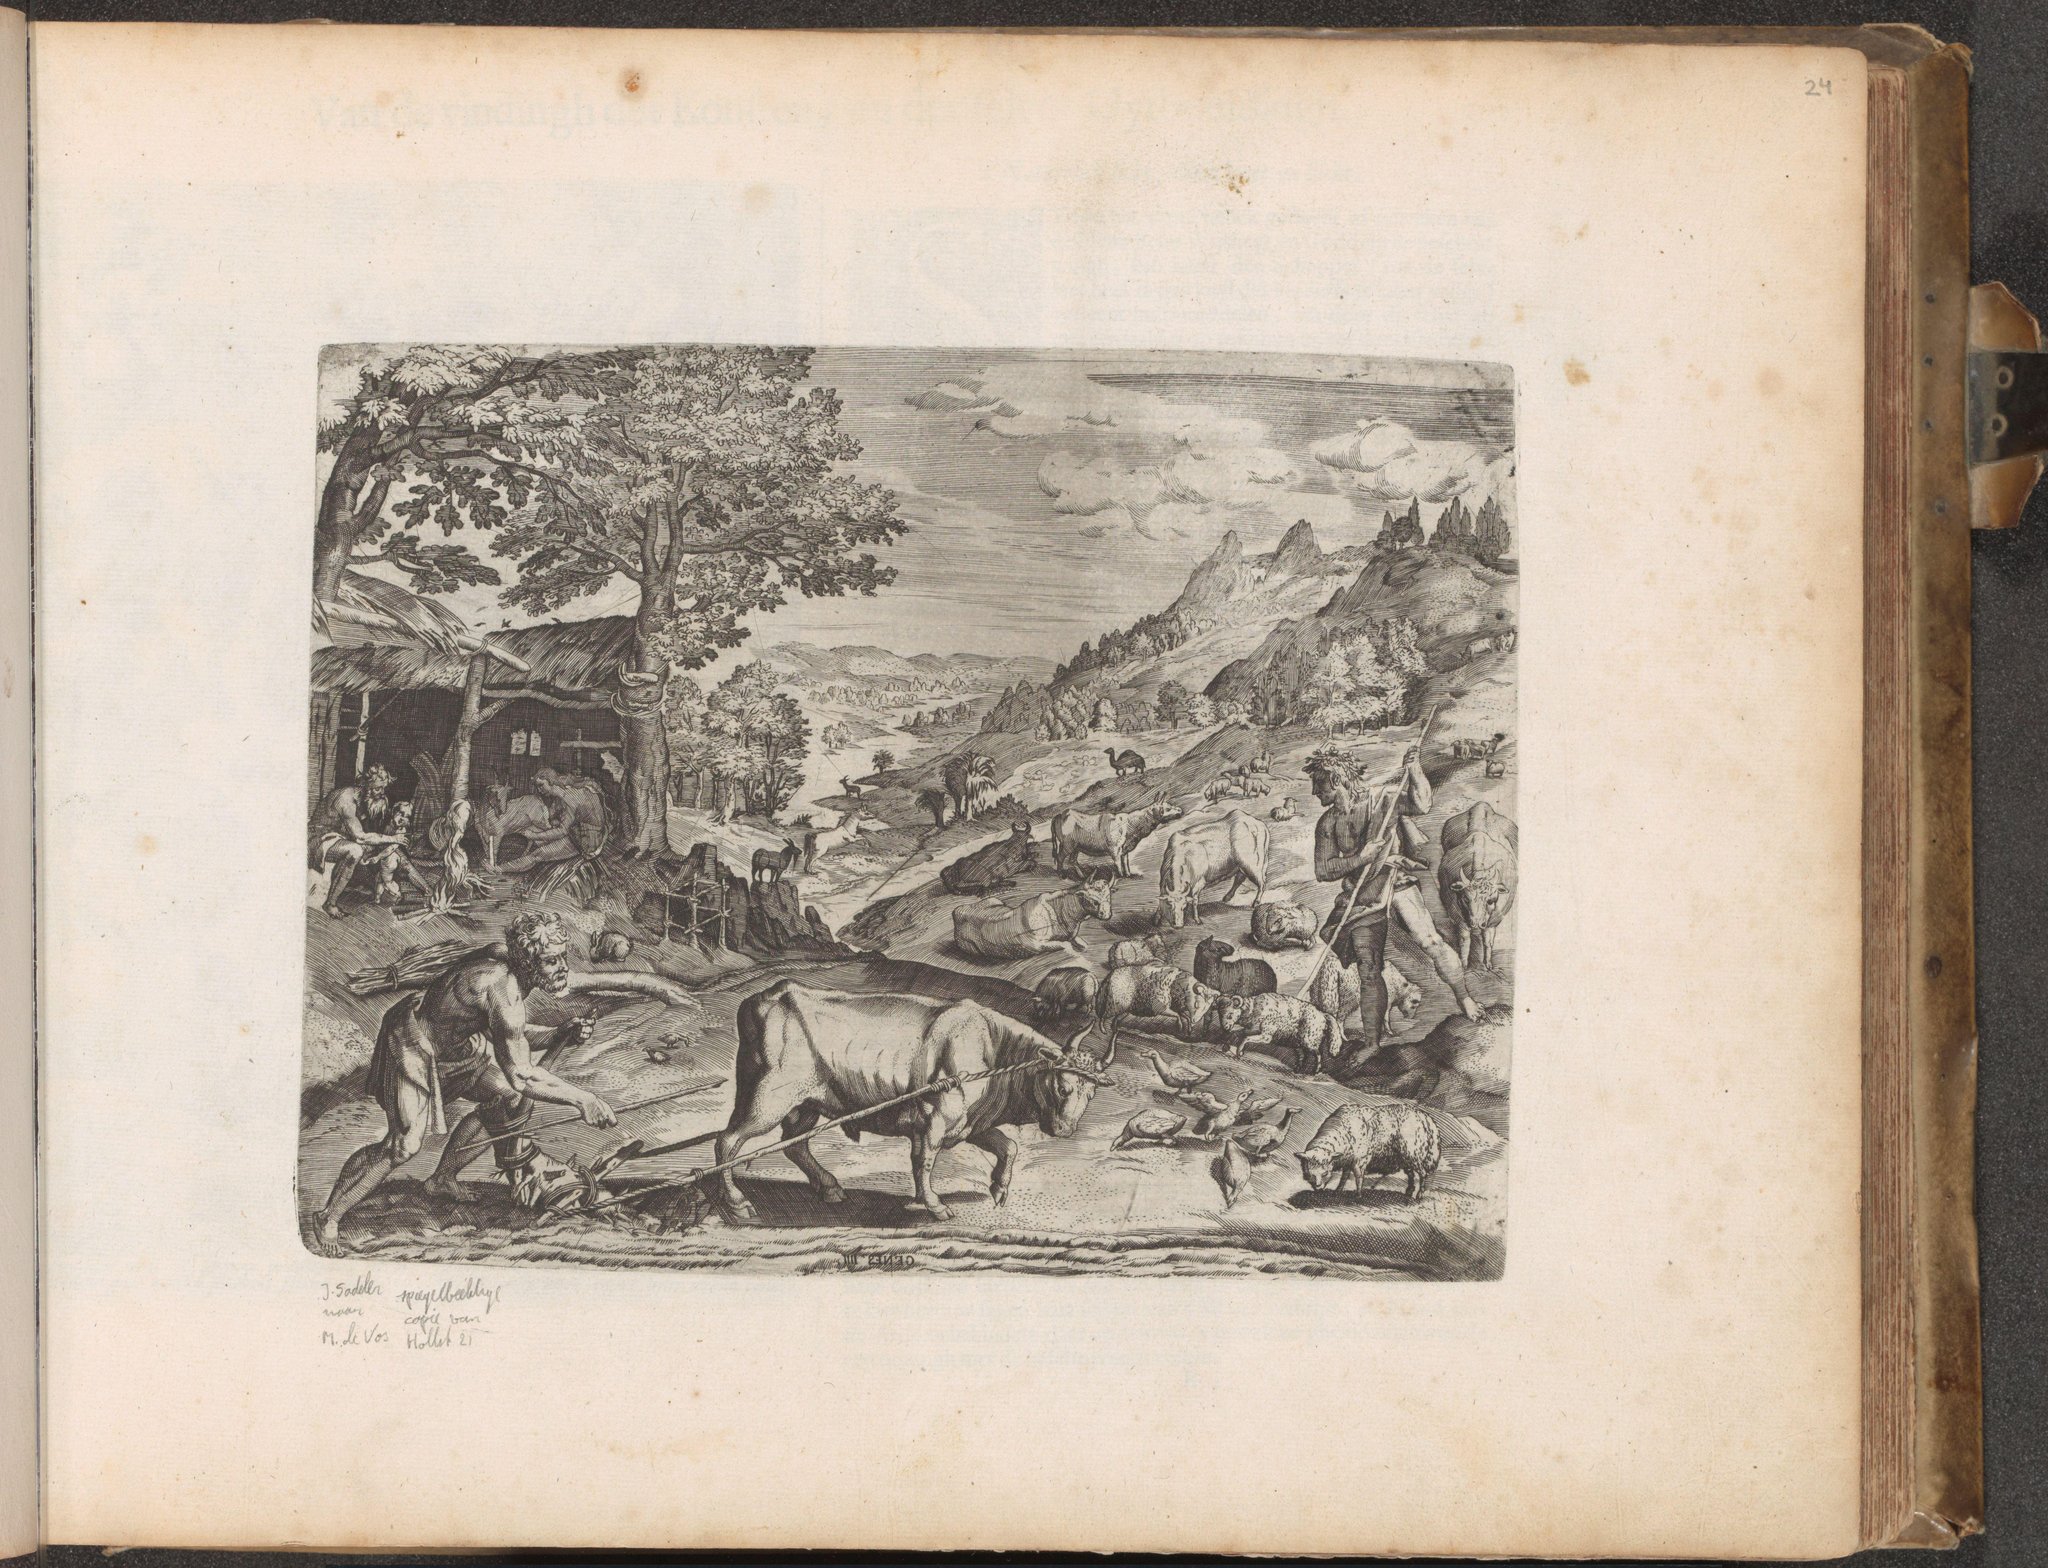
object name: album leaf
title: Den Grooten Emblemata Sacra, bestaande in meer dan vier hondert bybelsche figuren, zoo des Ouden als des Nieuwen Testaments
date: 1583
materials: paper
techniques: engraving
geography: amsterdam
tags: cain and abel learn to assist their father; cain by farming, abel by herding, animals, old testament, declining years and death of adam and eve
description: Kaïn ploegt een veld met een trekos. Rechts zorgt Abel voor een kudde koeien en schapen. Op de achtergrond links de hut van Adam en Eva. Midden onder een verwijzing (in spiegelbeeld) naar de Bijbeltekst in Gen. 4. De prent maakt deel uit van een album.